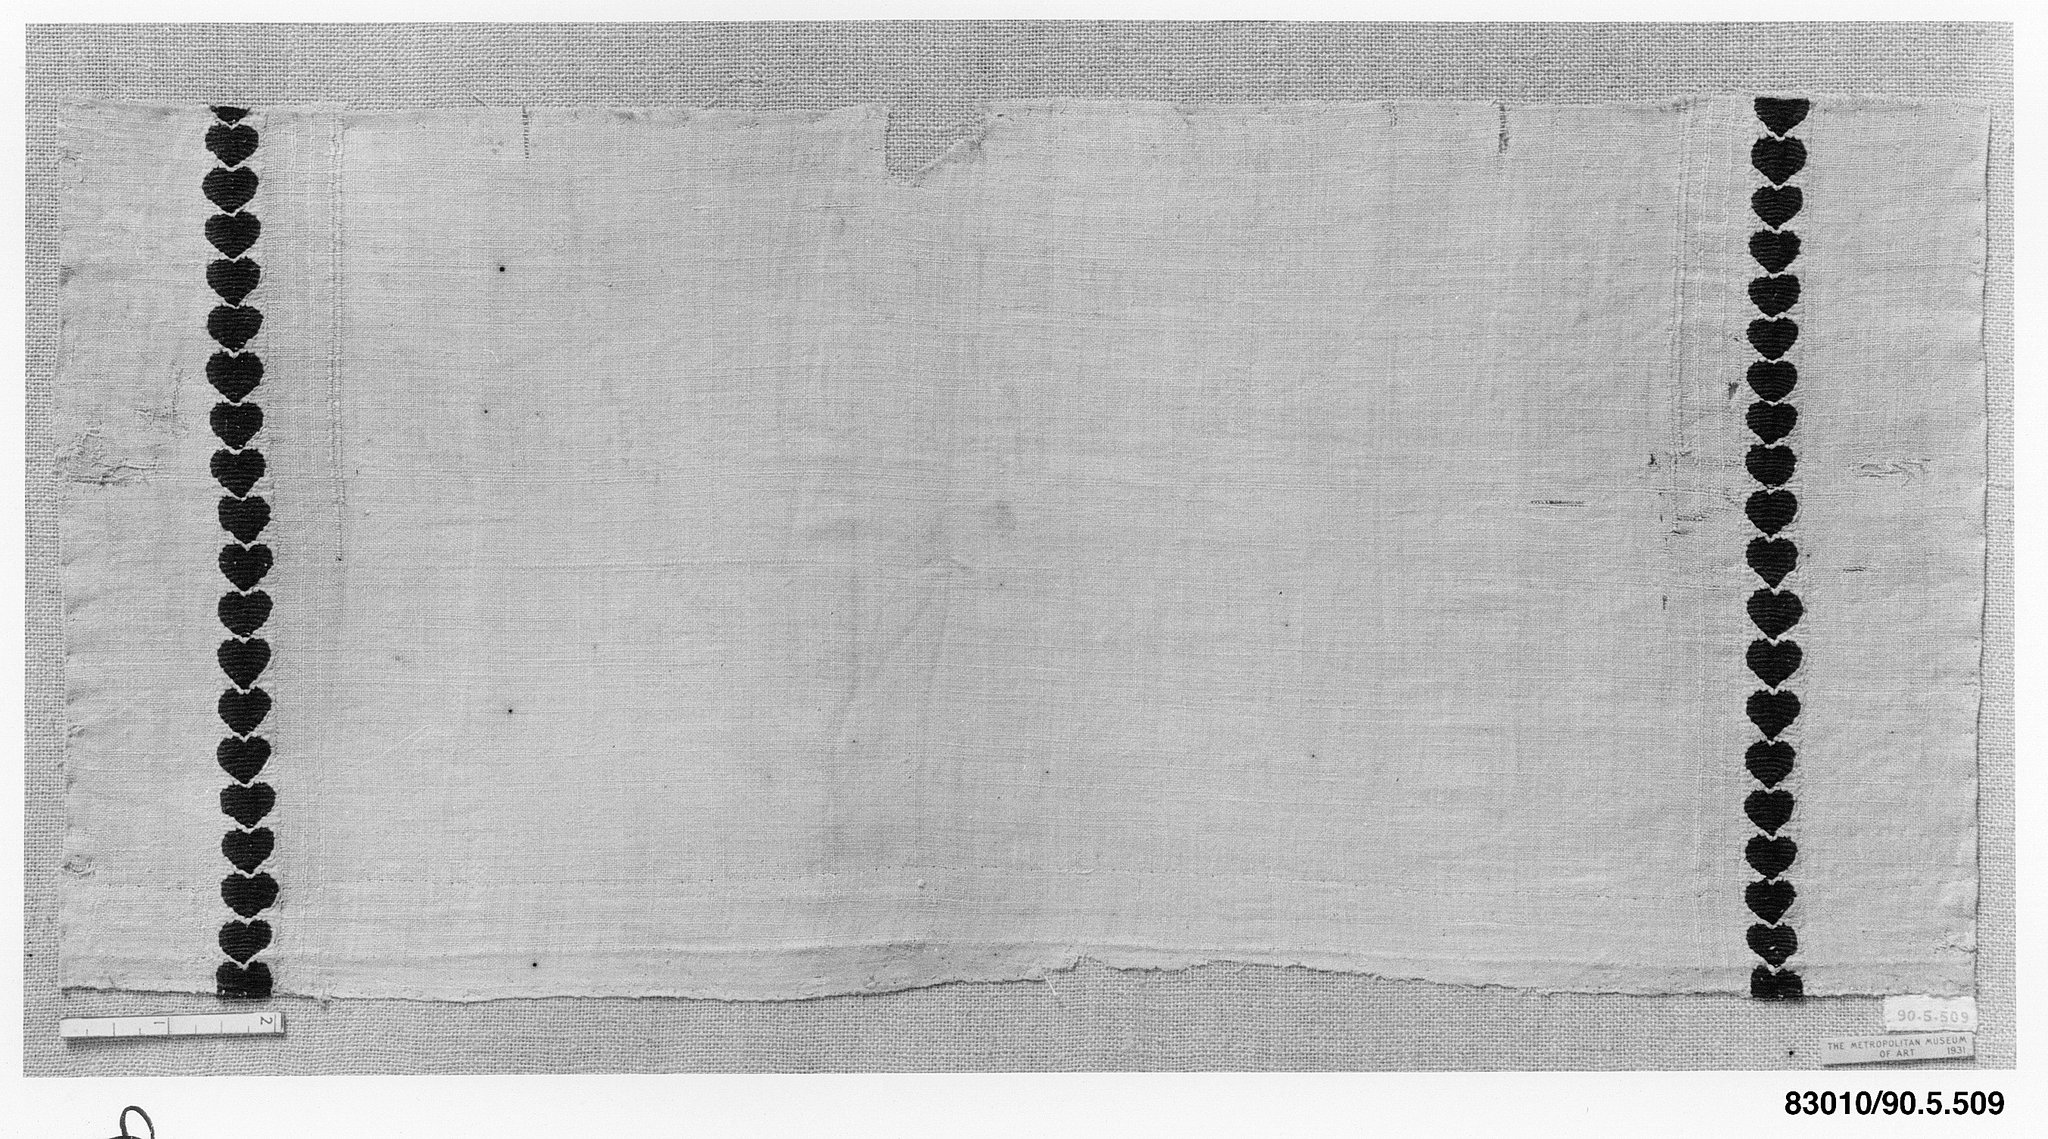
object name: textile fragment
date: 201-400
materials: linen, wool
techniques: weave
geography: egypt